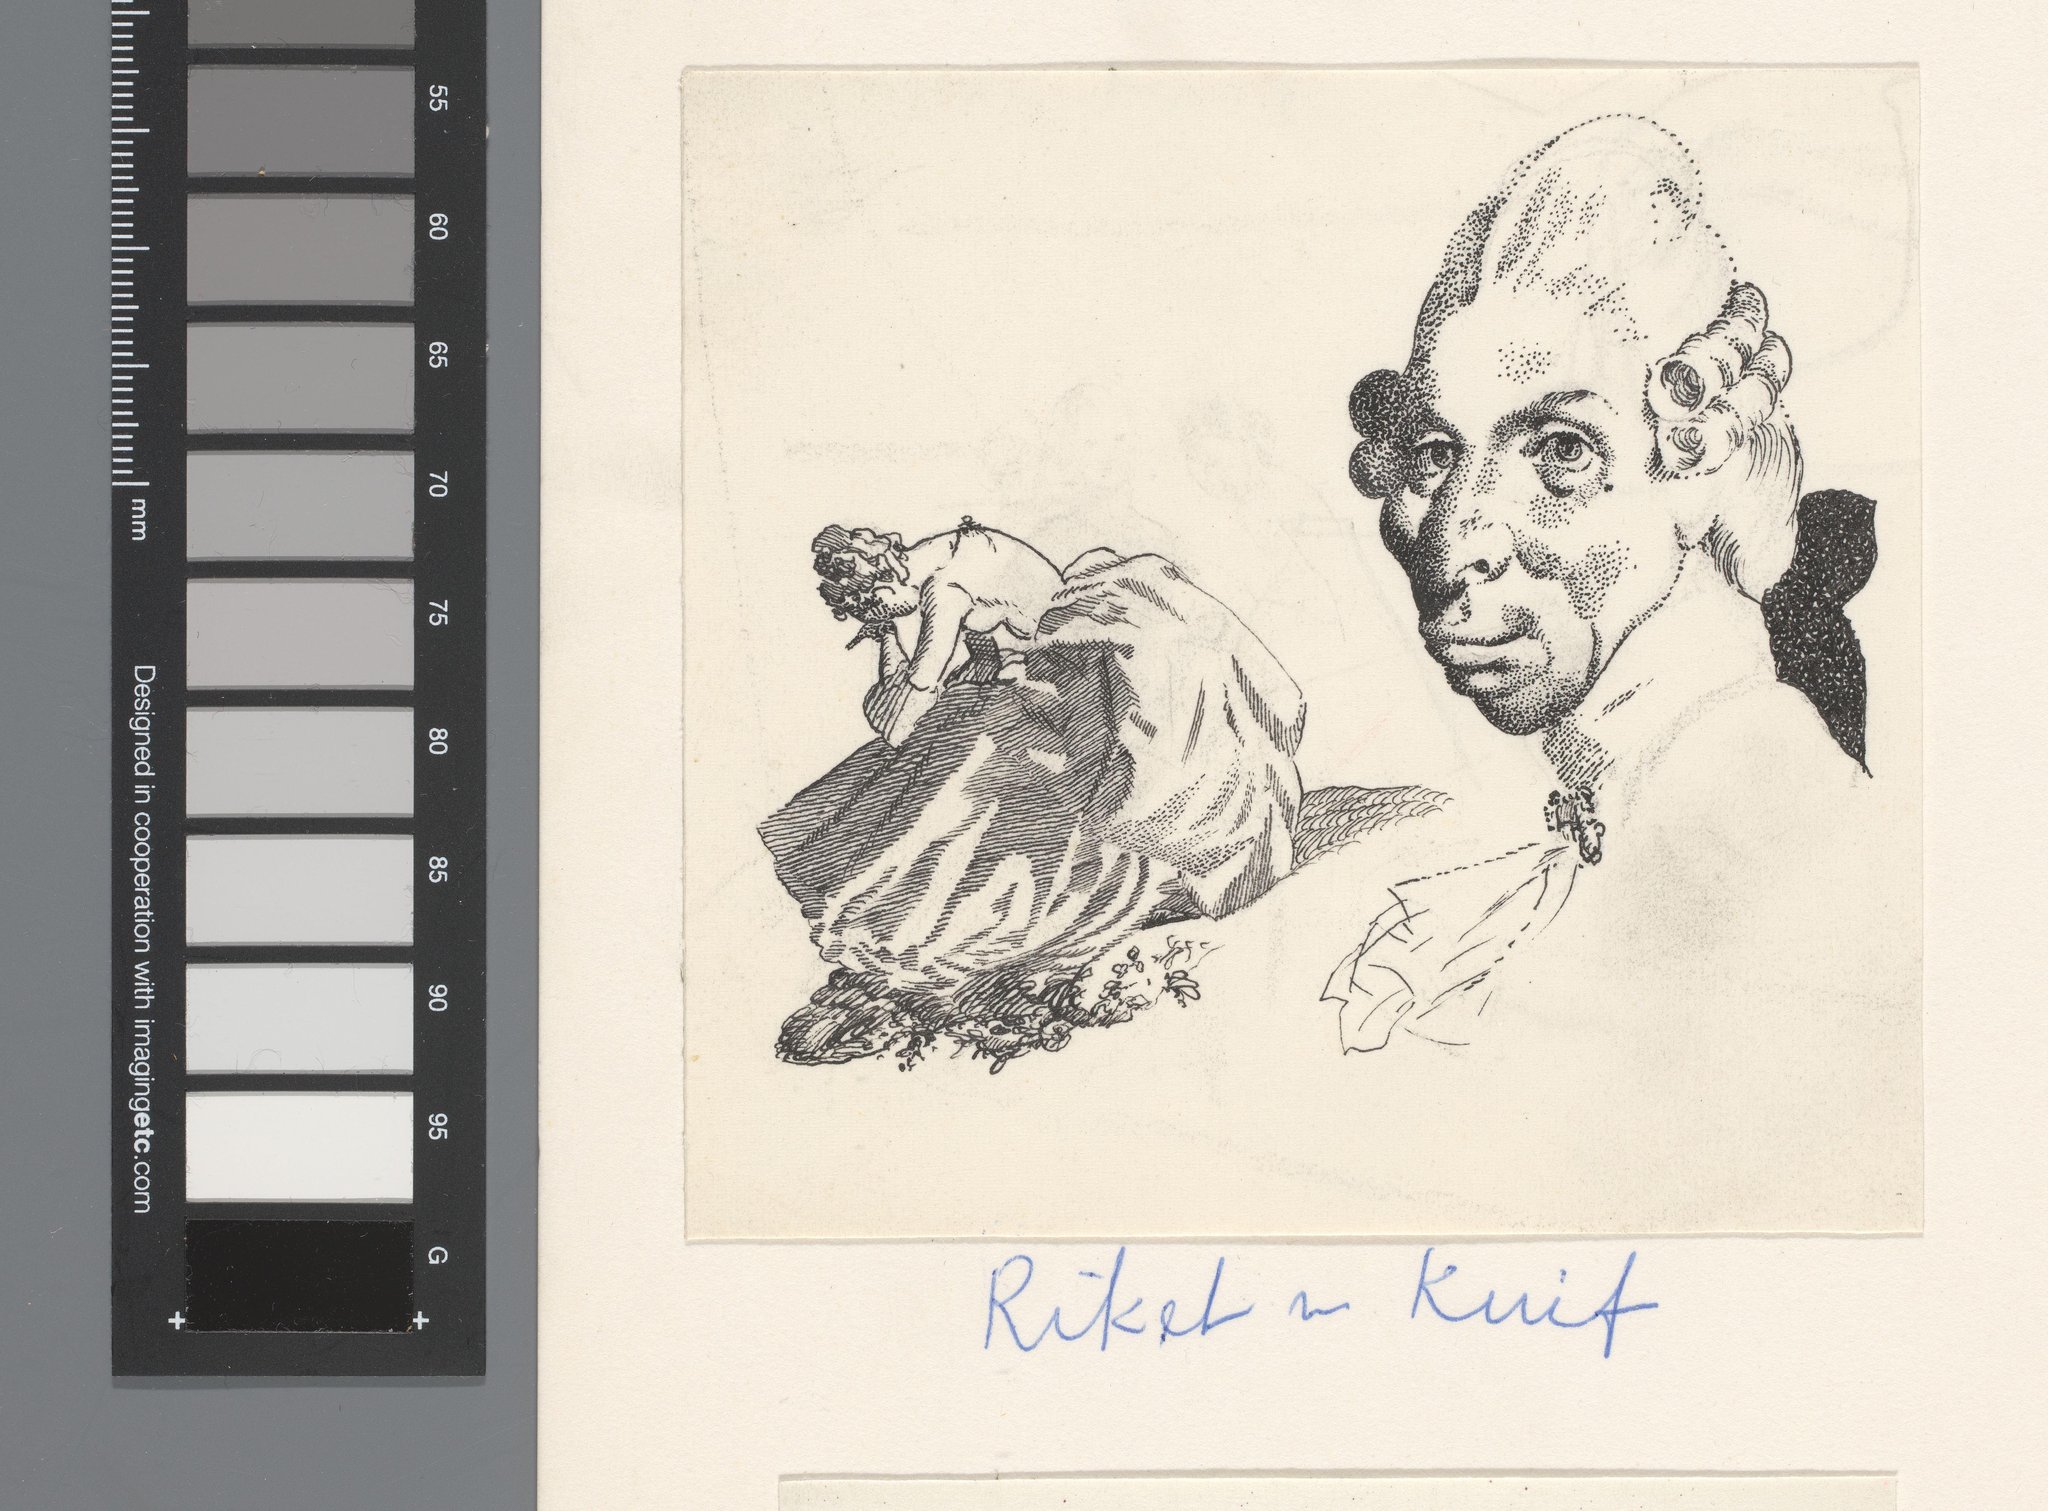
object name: boekillustratie ontwerp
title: Treurende prinses en Riket met de Kuif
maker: Anonymous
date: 1900-1950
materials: ink, paper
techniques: pen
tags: weeping, tales and fairy tales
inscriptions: annotation: ‘Riket m Kuif’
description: De prinses zit voorovergebogen te treuren op de grond. Rechts het portret van Riket met de Kuif.